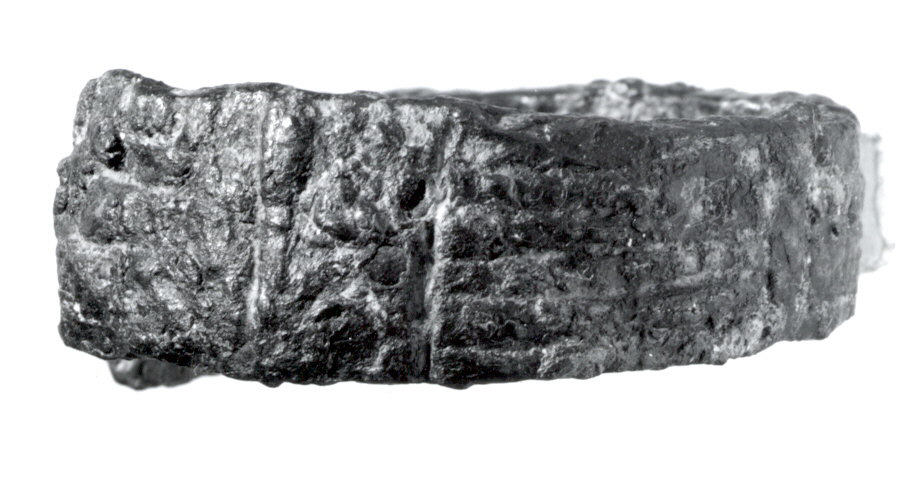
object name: bracelet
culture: iranian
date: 800-601 BCE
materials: iron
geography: western iran